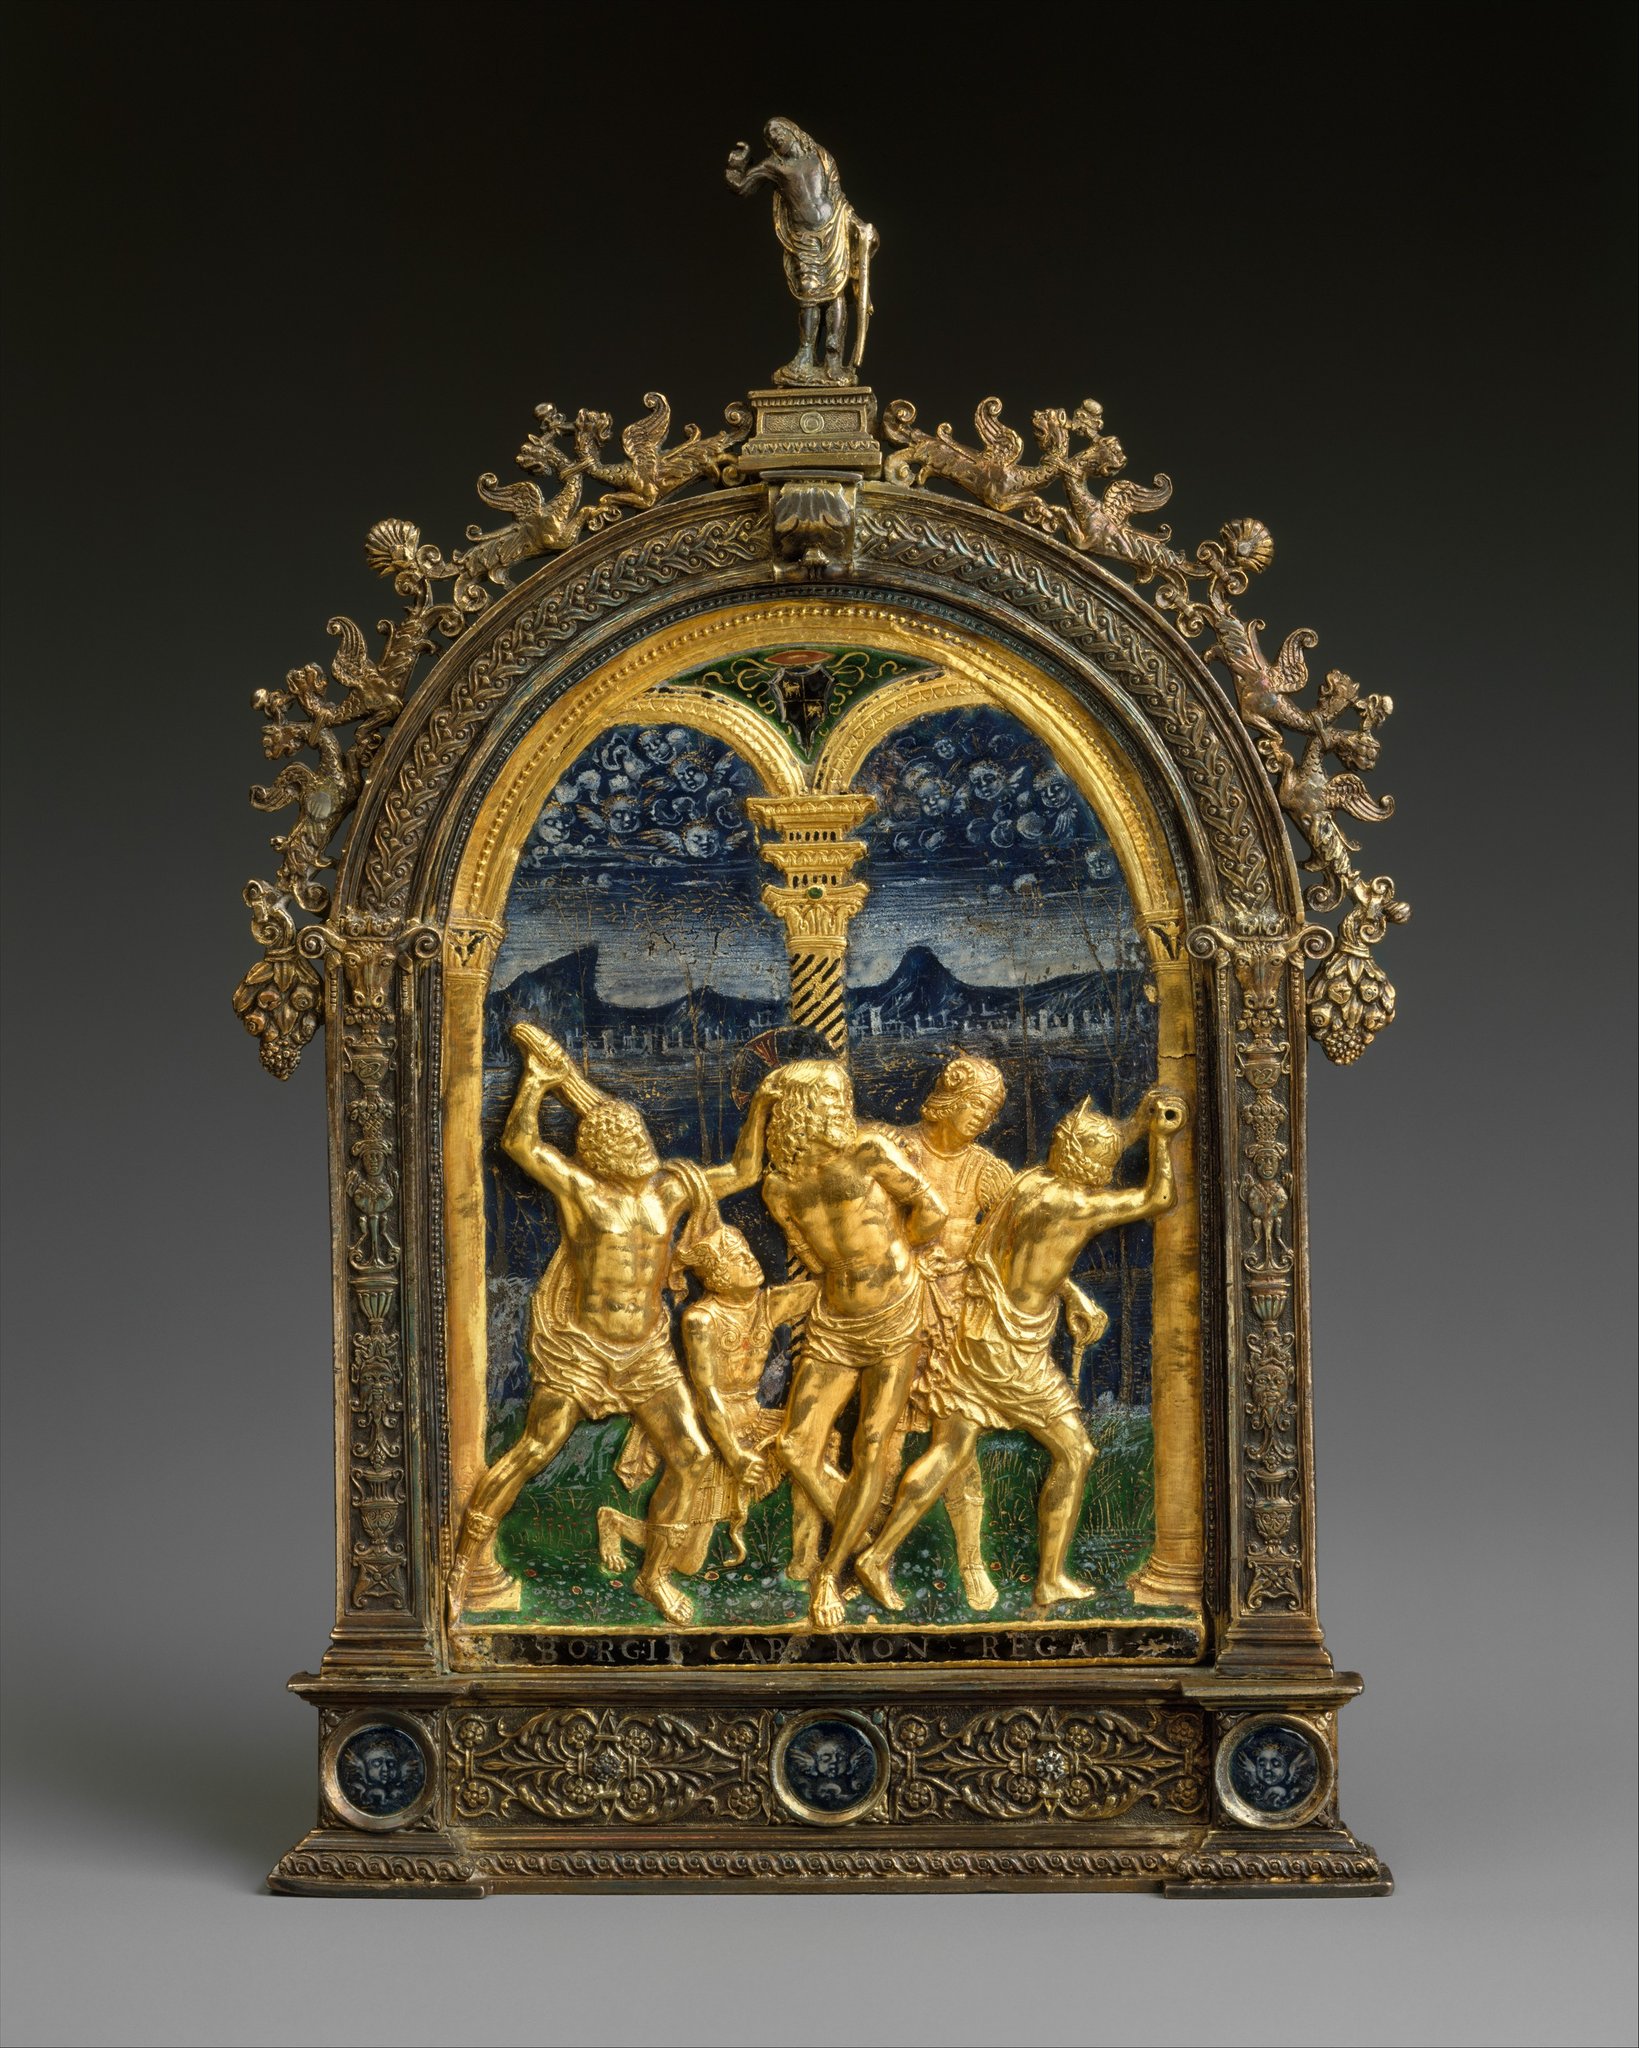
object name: pax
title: The Flagellation of Christ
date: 1492-1503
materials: silver gilt, gold, silver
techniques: enamel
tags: men,christ